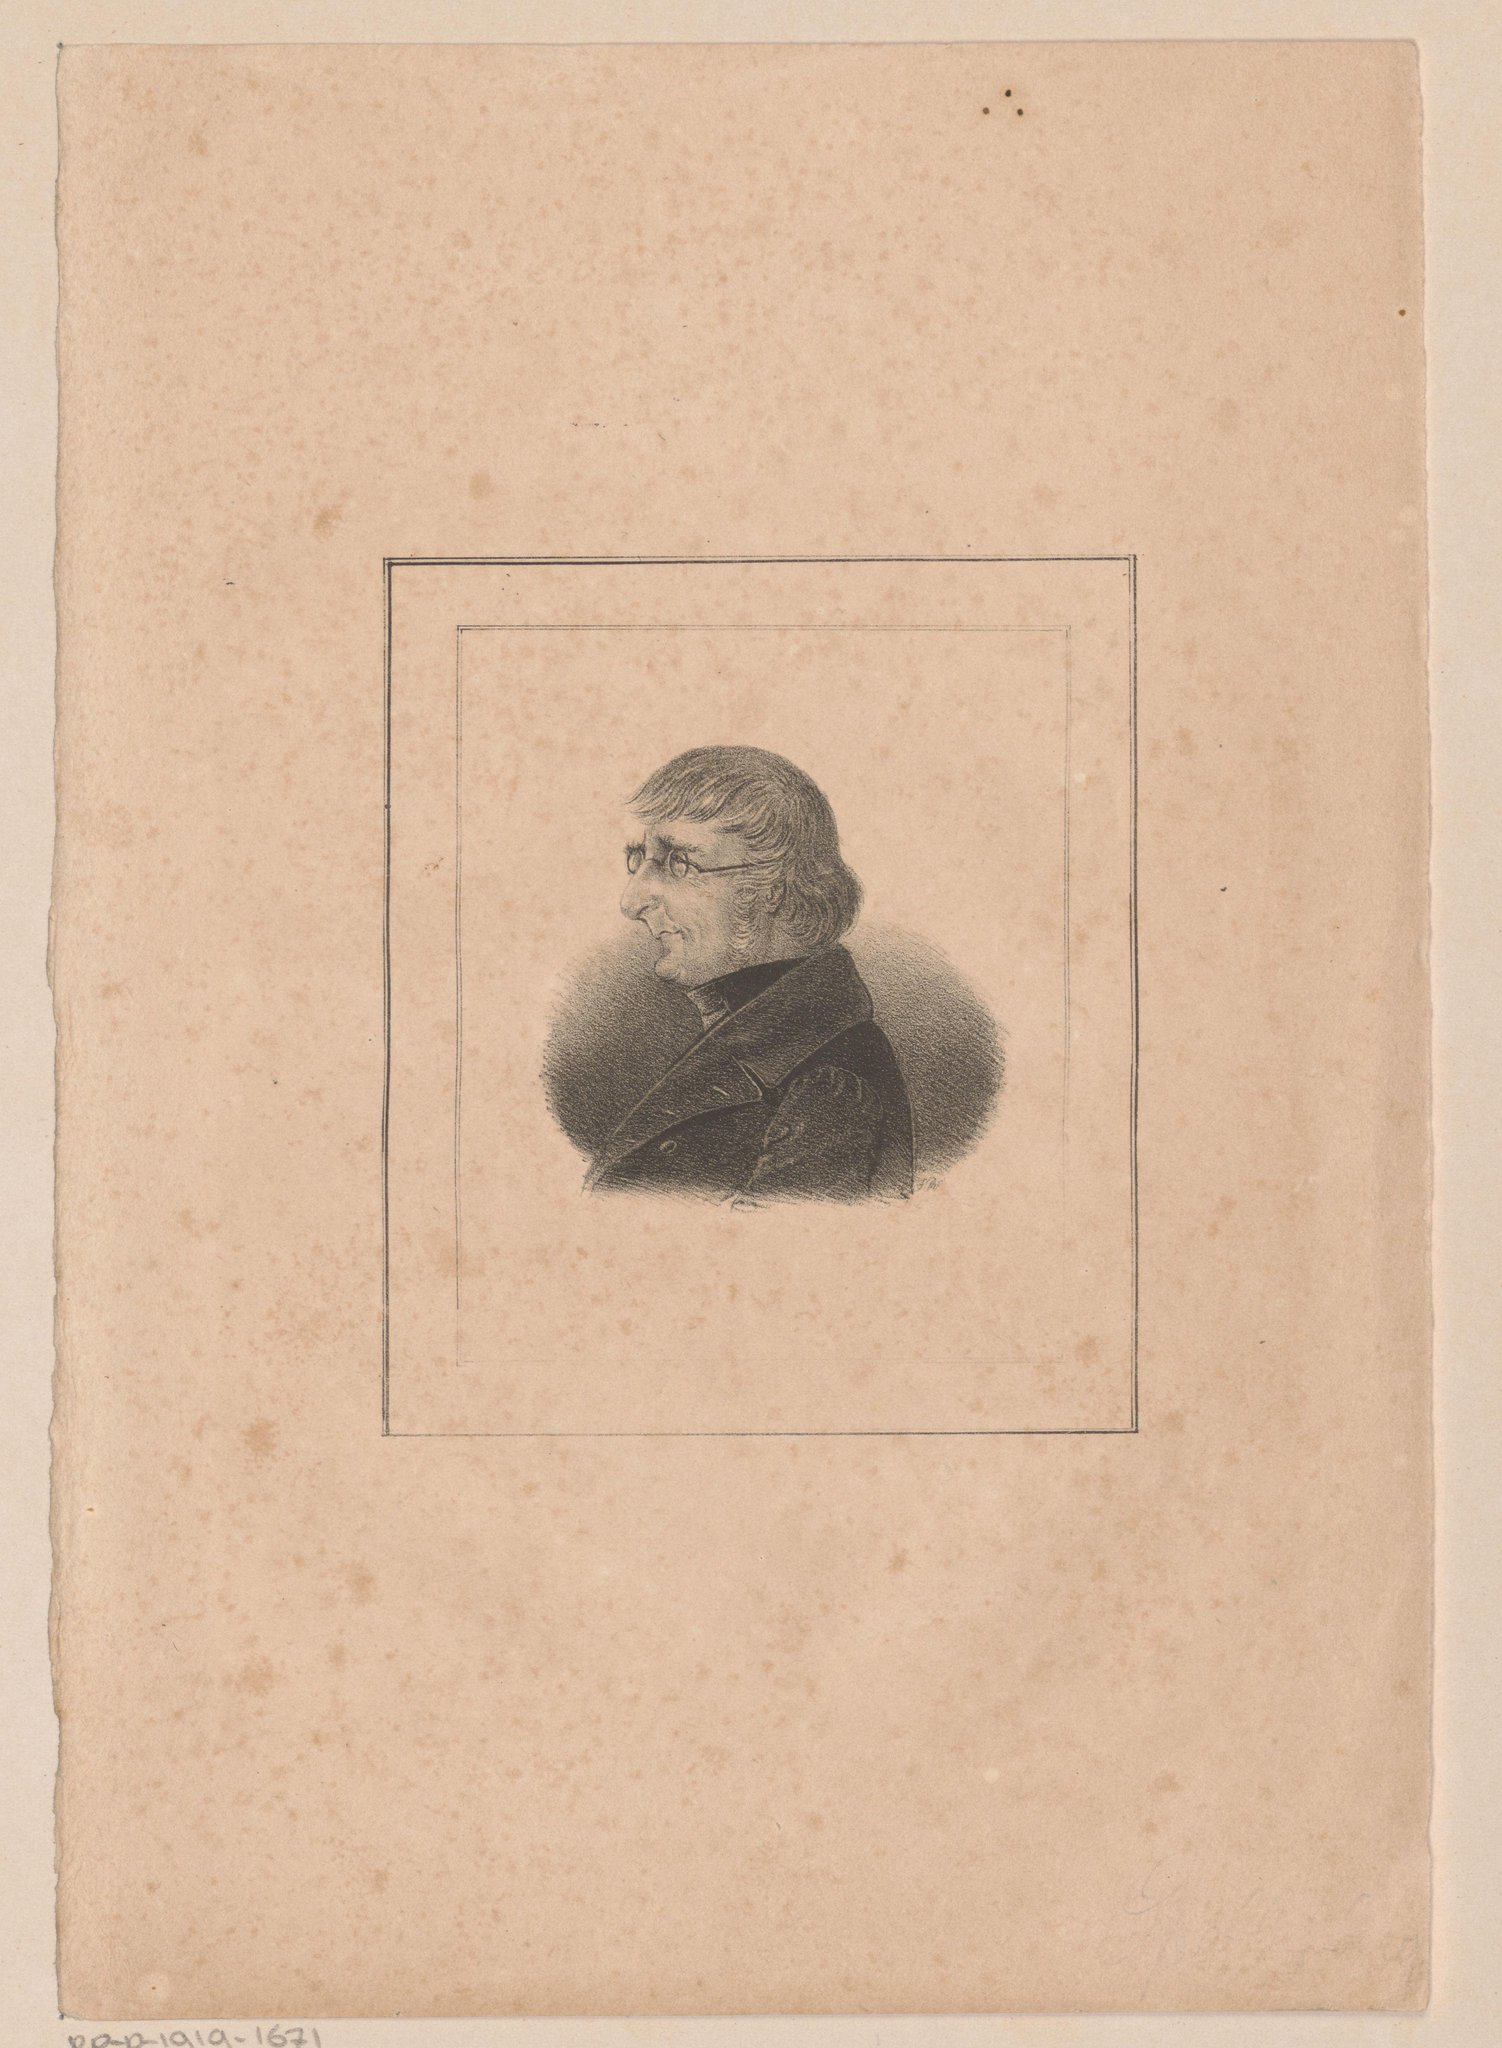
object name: print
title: Portret van een onbekende man met bril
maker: Anonymous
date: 1798-1899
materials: paper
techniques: lithograph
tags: historical persons not known by name